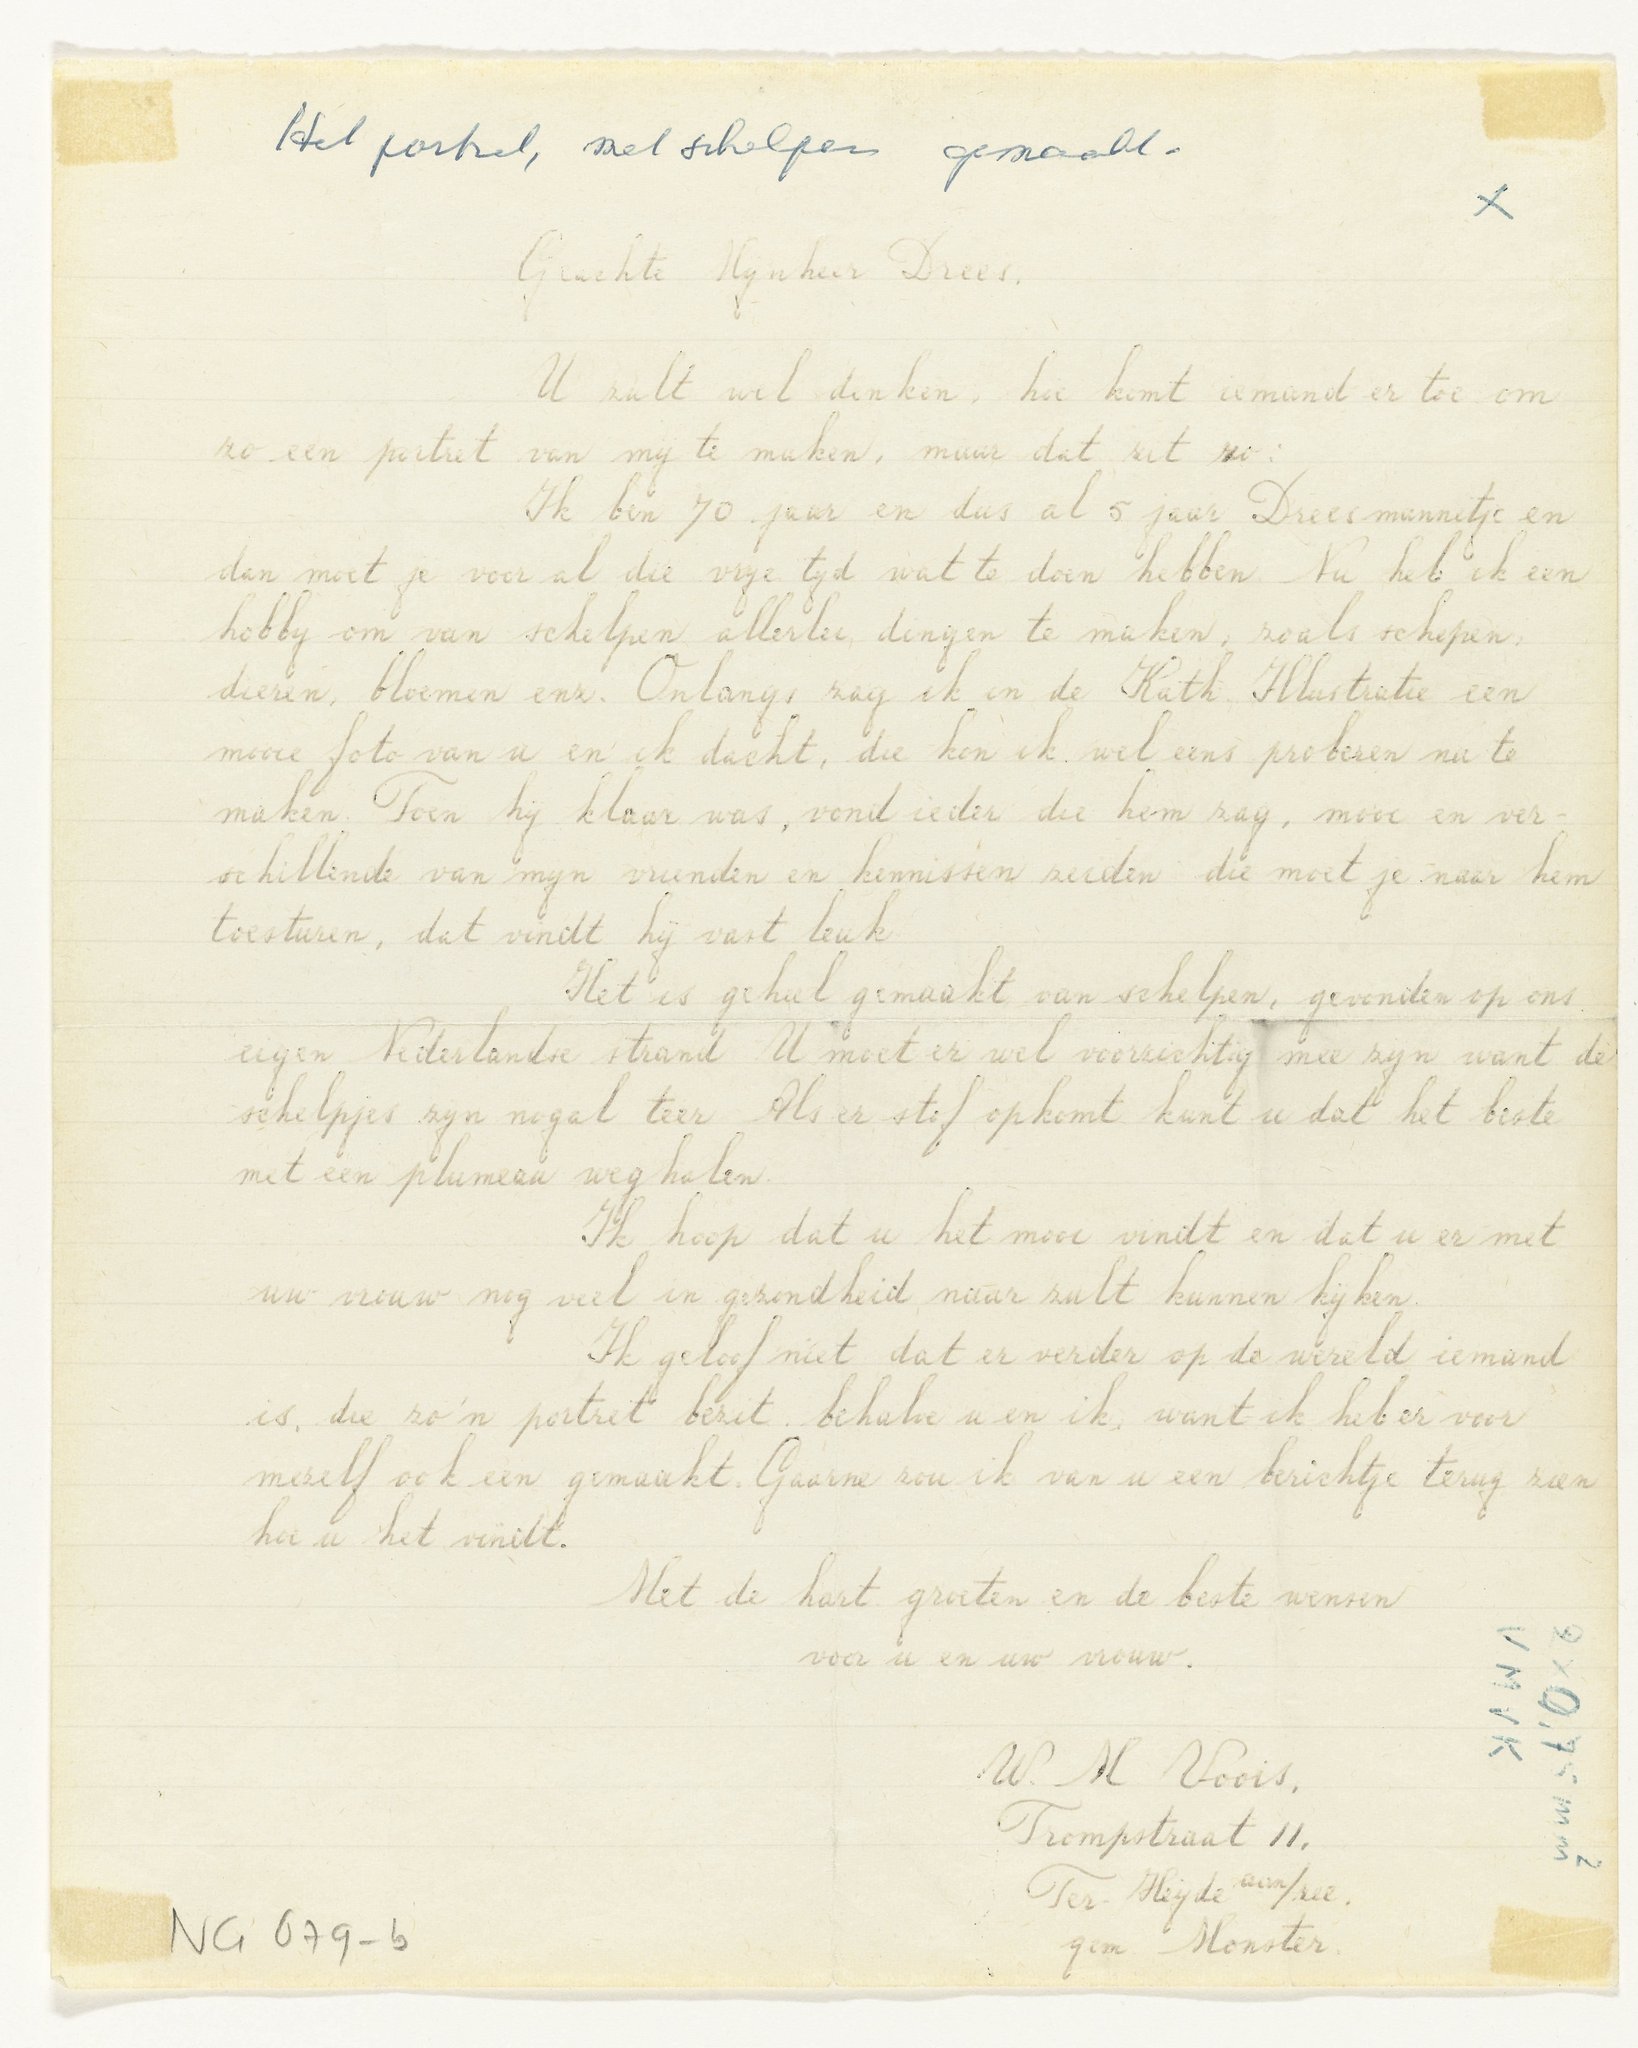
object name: letter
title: Brief over schelpenportret aan Willem Drees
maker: w.m. voois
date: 1960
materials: paper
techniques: pen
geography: ter heijde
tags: amsterdam, the hague, willem drees, netherlands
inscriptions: signature: ‘W.M. Voois’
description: Shell portrait with letter, January 1967. M. Voois of Ter Heijde aan Zee used shells he had collected at the beach to make this touching portrait of Drees for his 80th birthday.